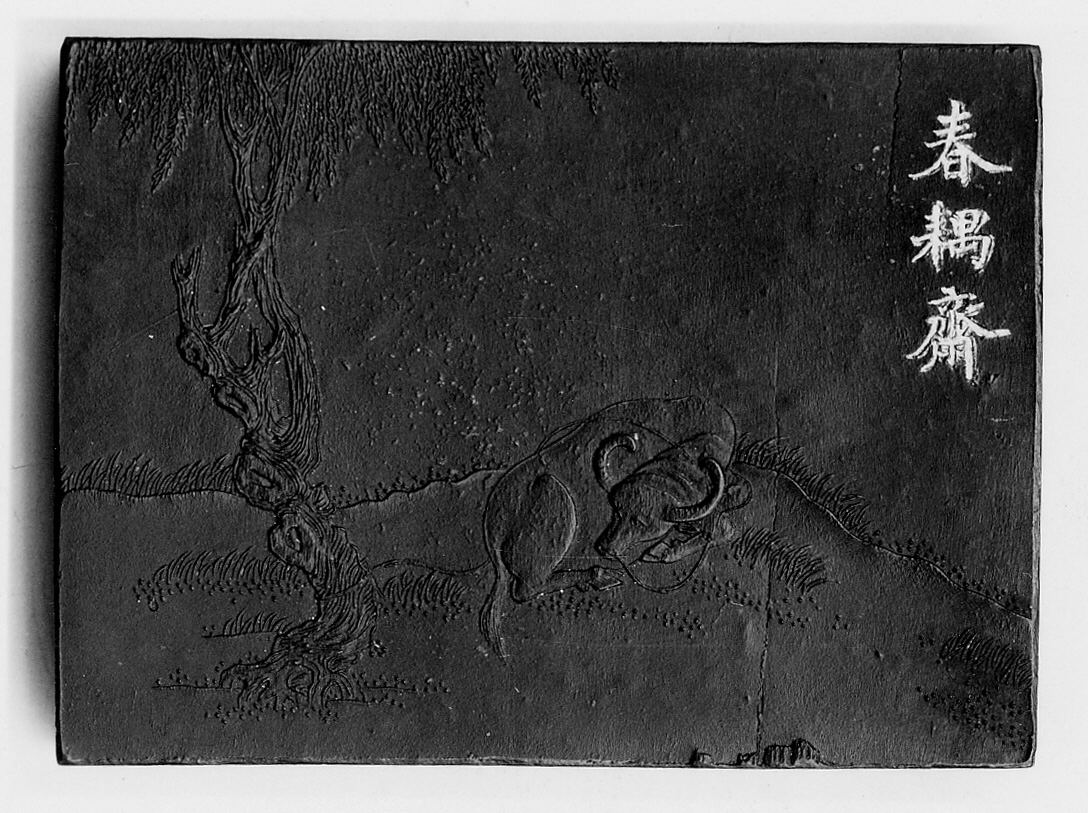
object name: ink tablet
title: Spring Ploughing Studio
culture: chinese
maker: jian guzhai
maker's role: artist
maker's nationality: chinese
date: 1867-1933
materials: gilt, wood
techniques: bookbinding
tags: animals,trees